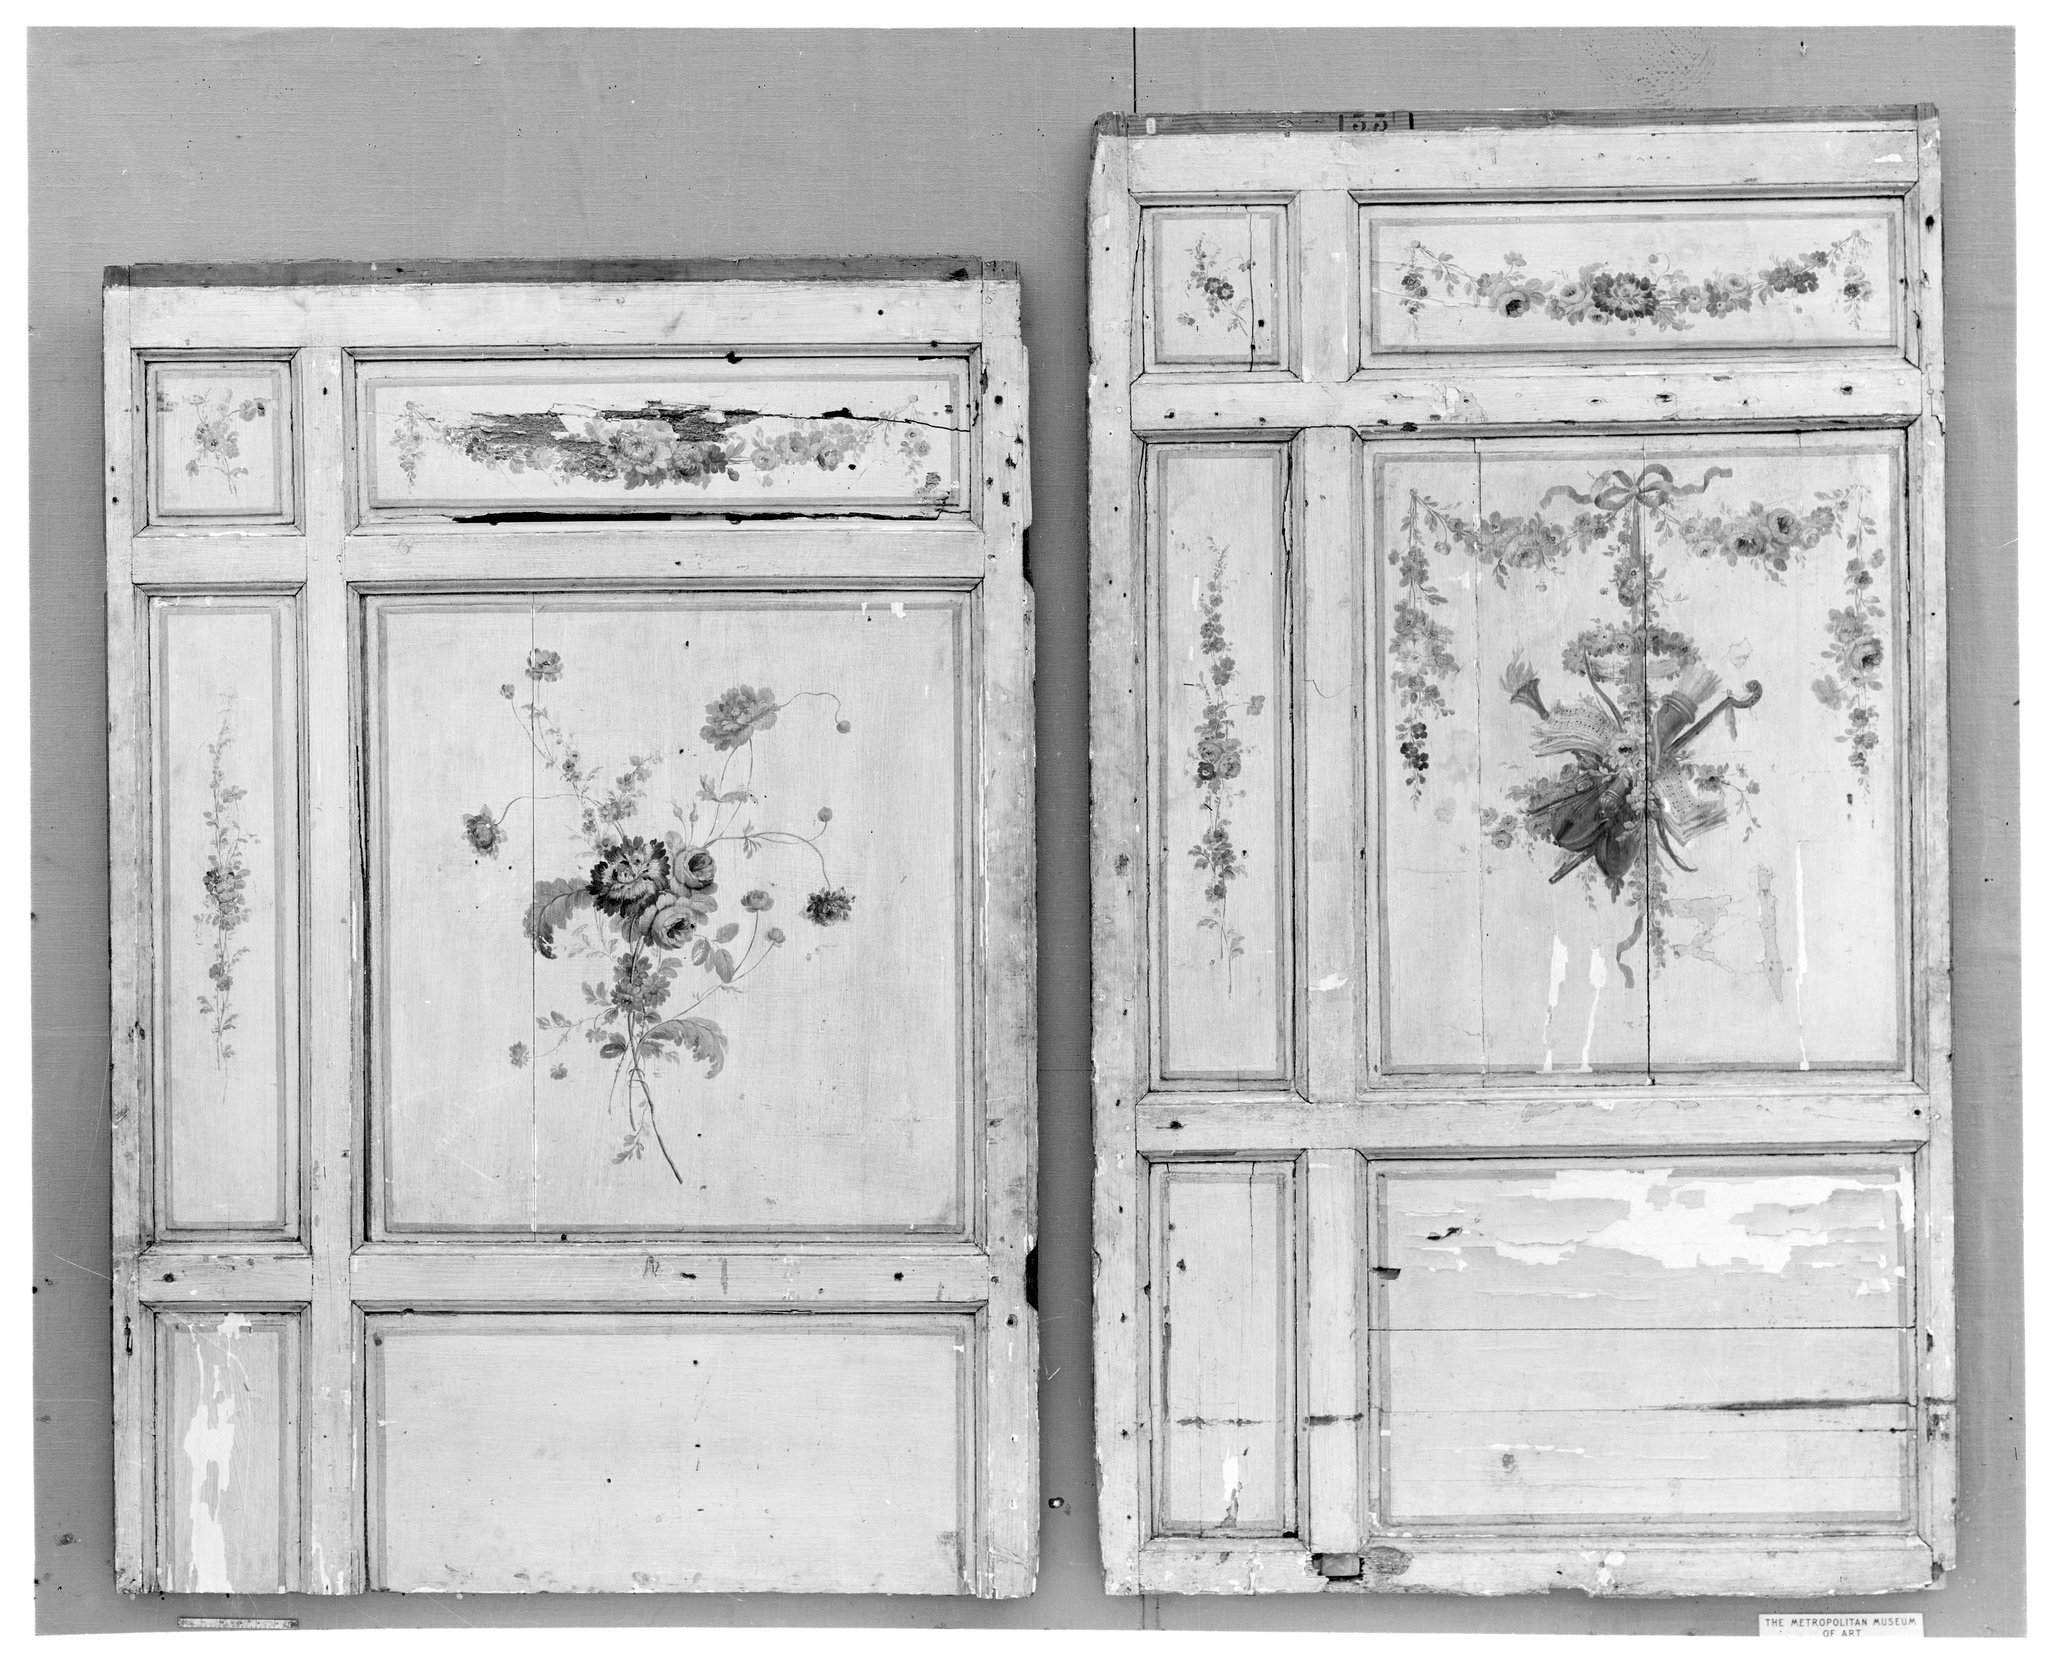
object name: wall paneling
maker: pierre ranson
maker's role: maker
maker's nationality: french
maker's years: 1736-1786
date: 1770-1780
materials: wood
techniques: painting